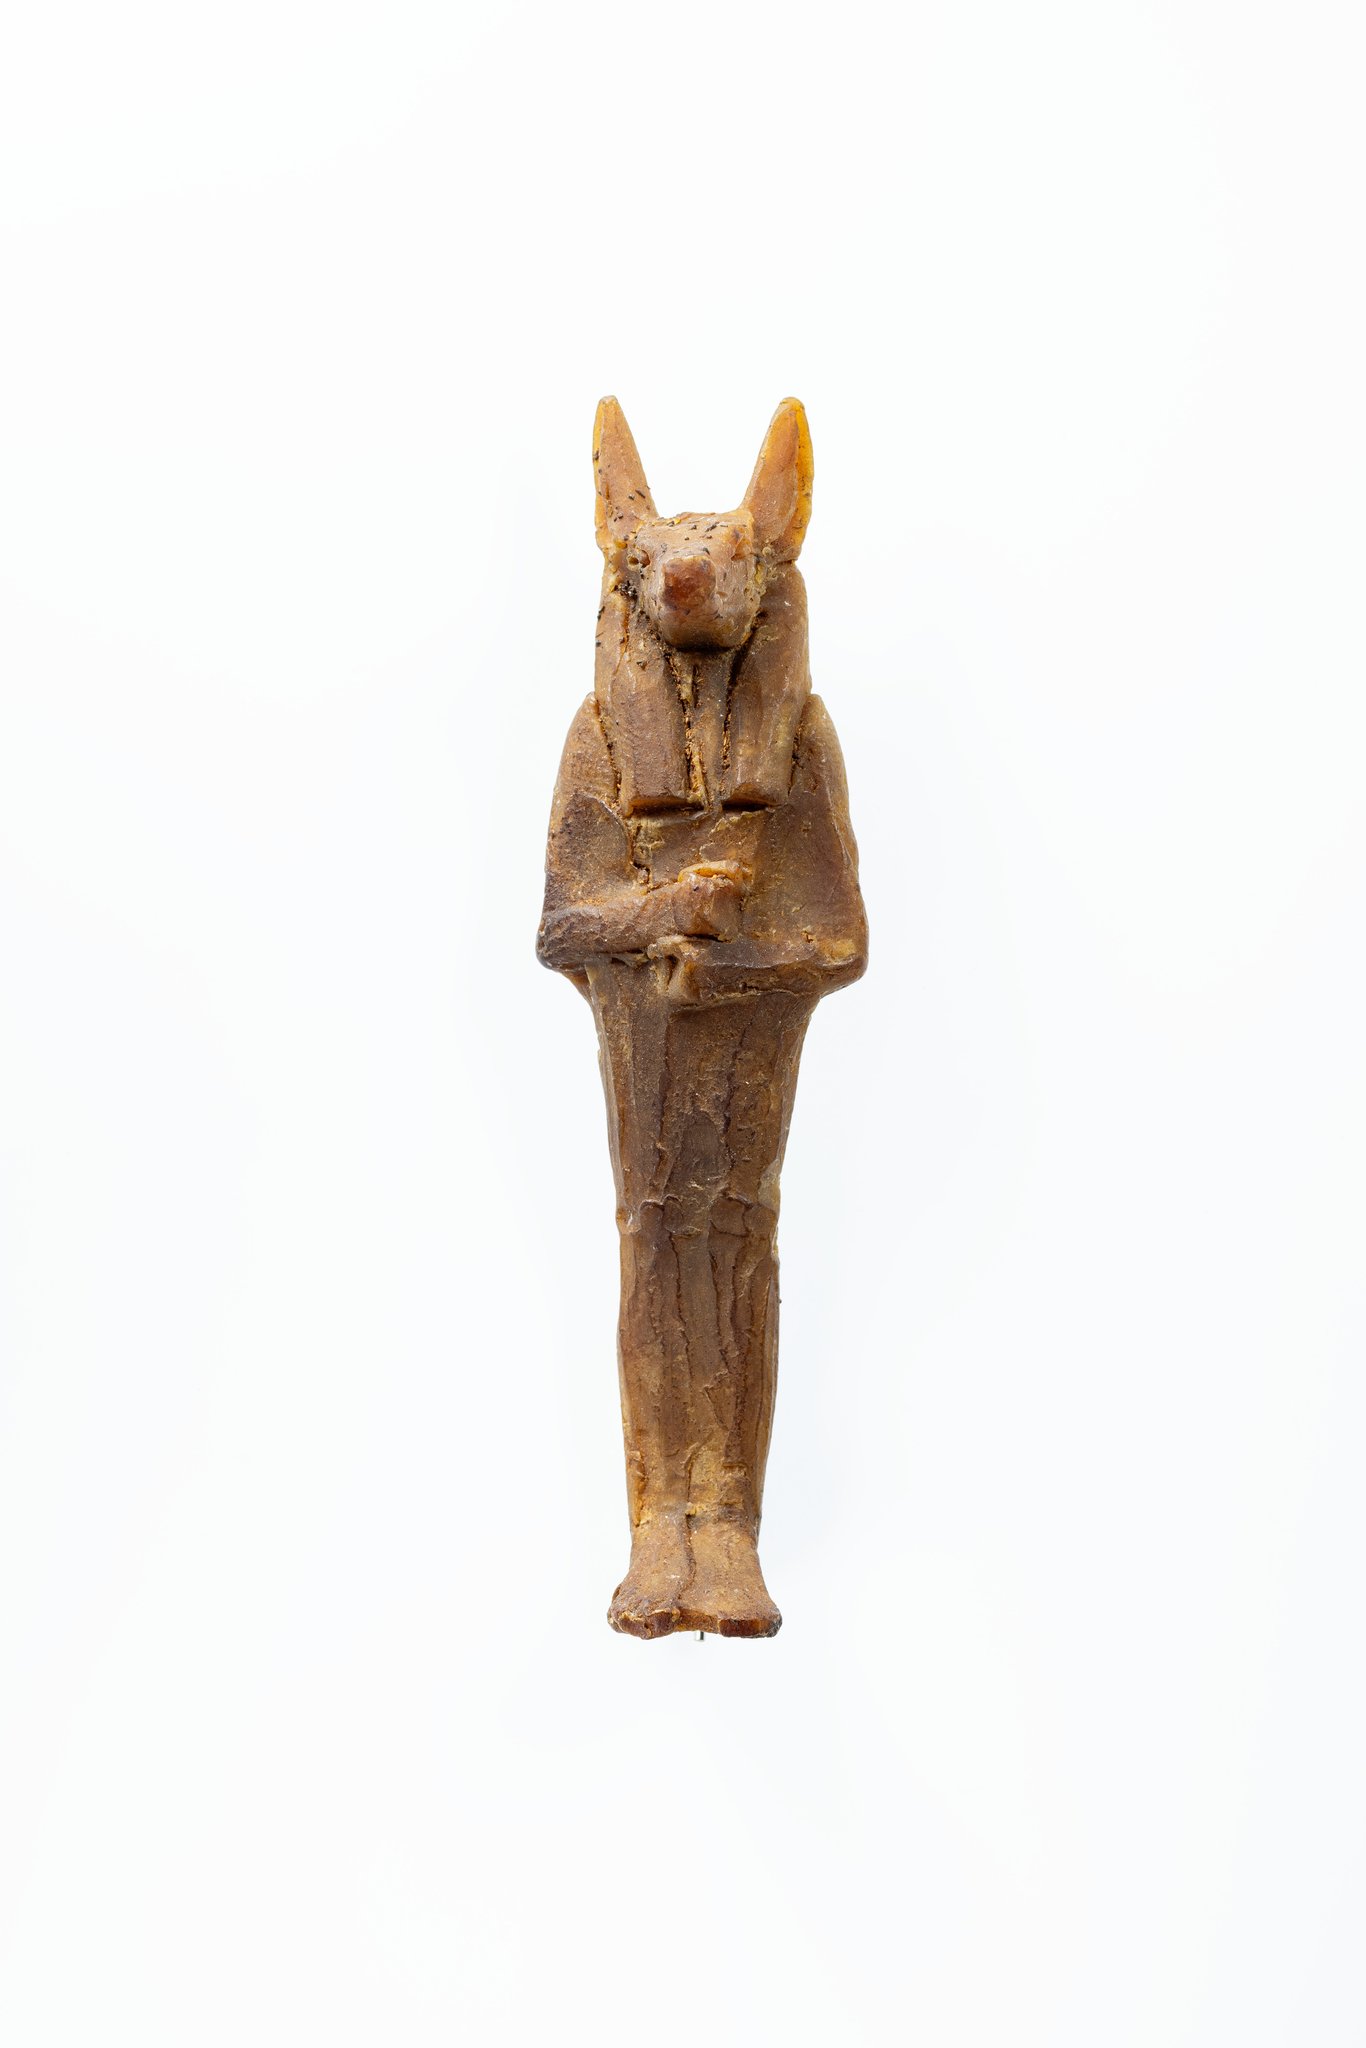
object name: funerary figure, duamutef, viscera figure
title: Viscera Figure of Duamutef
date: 1070-664 BCE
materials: wax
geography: egypt